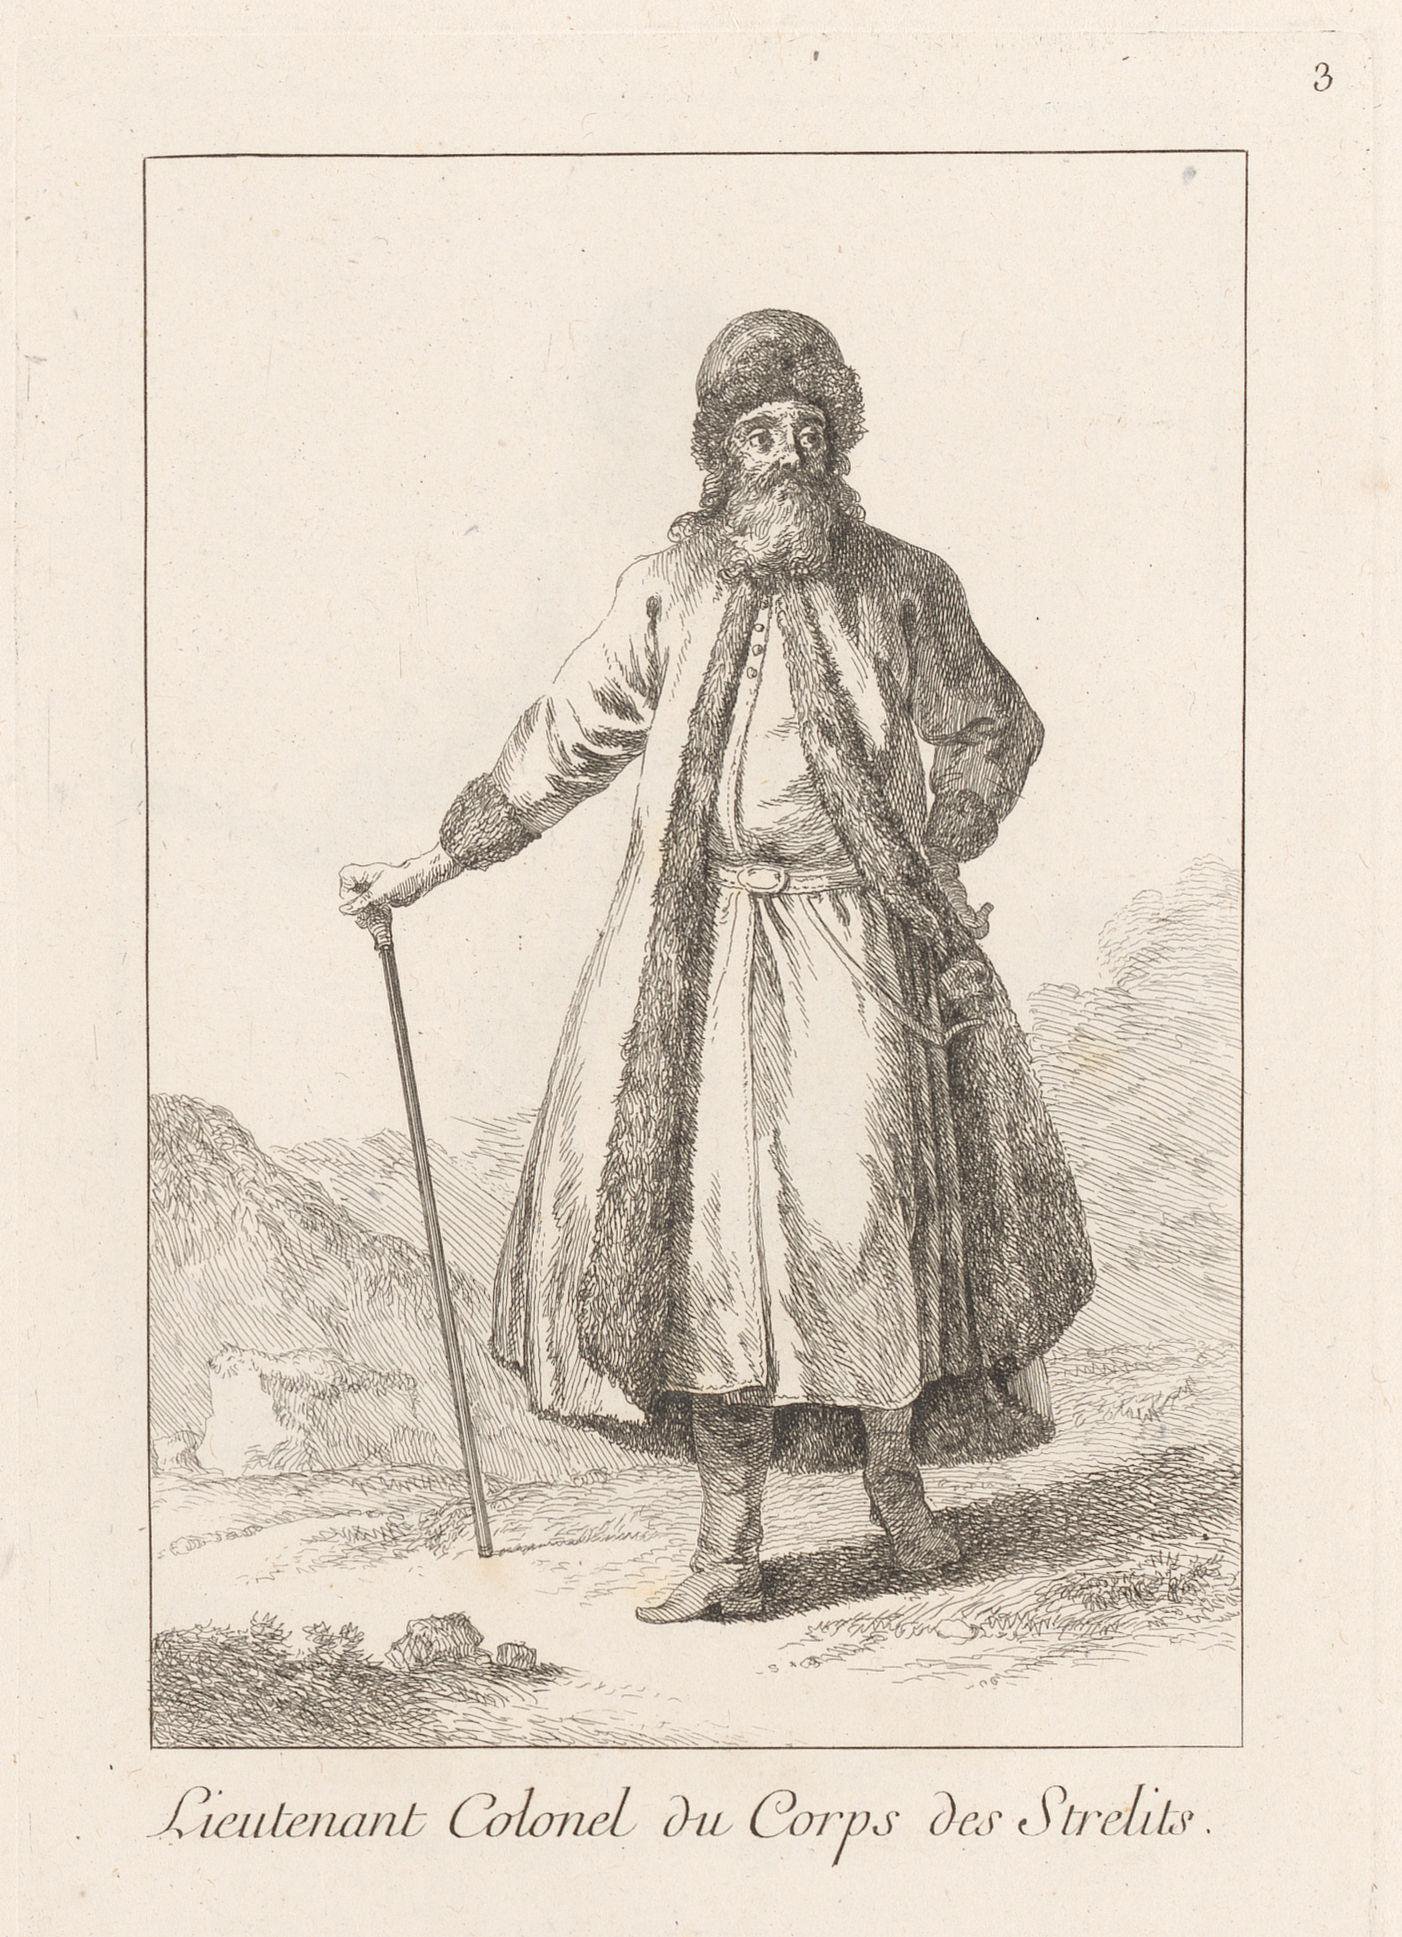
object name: album leaf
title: Soldaten uit de eenheid Strelitsen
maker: jean baptist leprince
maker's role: draughtsman, print maker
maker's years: 1734-1781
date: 1764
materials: paper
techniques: etching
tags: ranks in the army, land forces, firearms